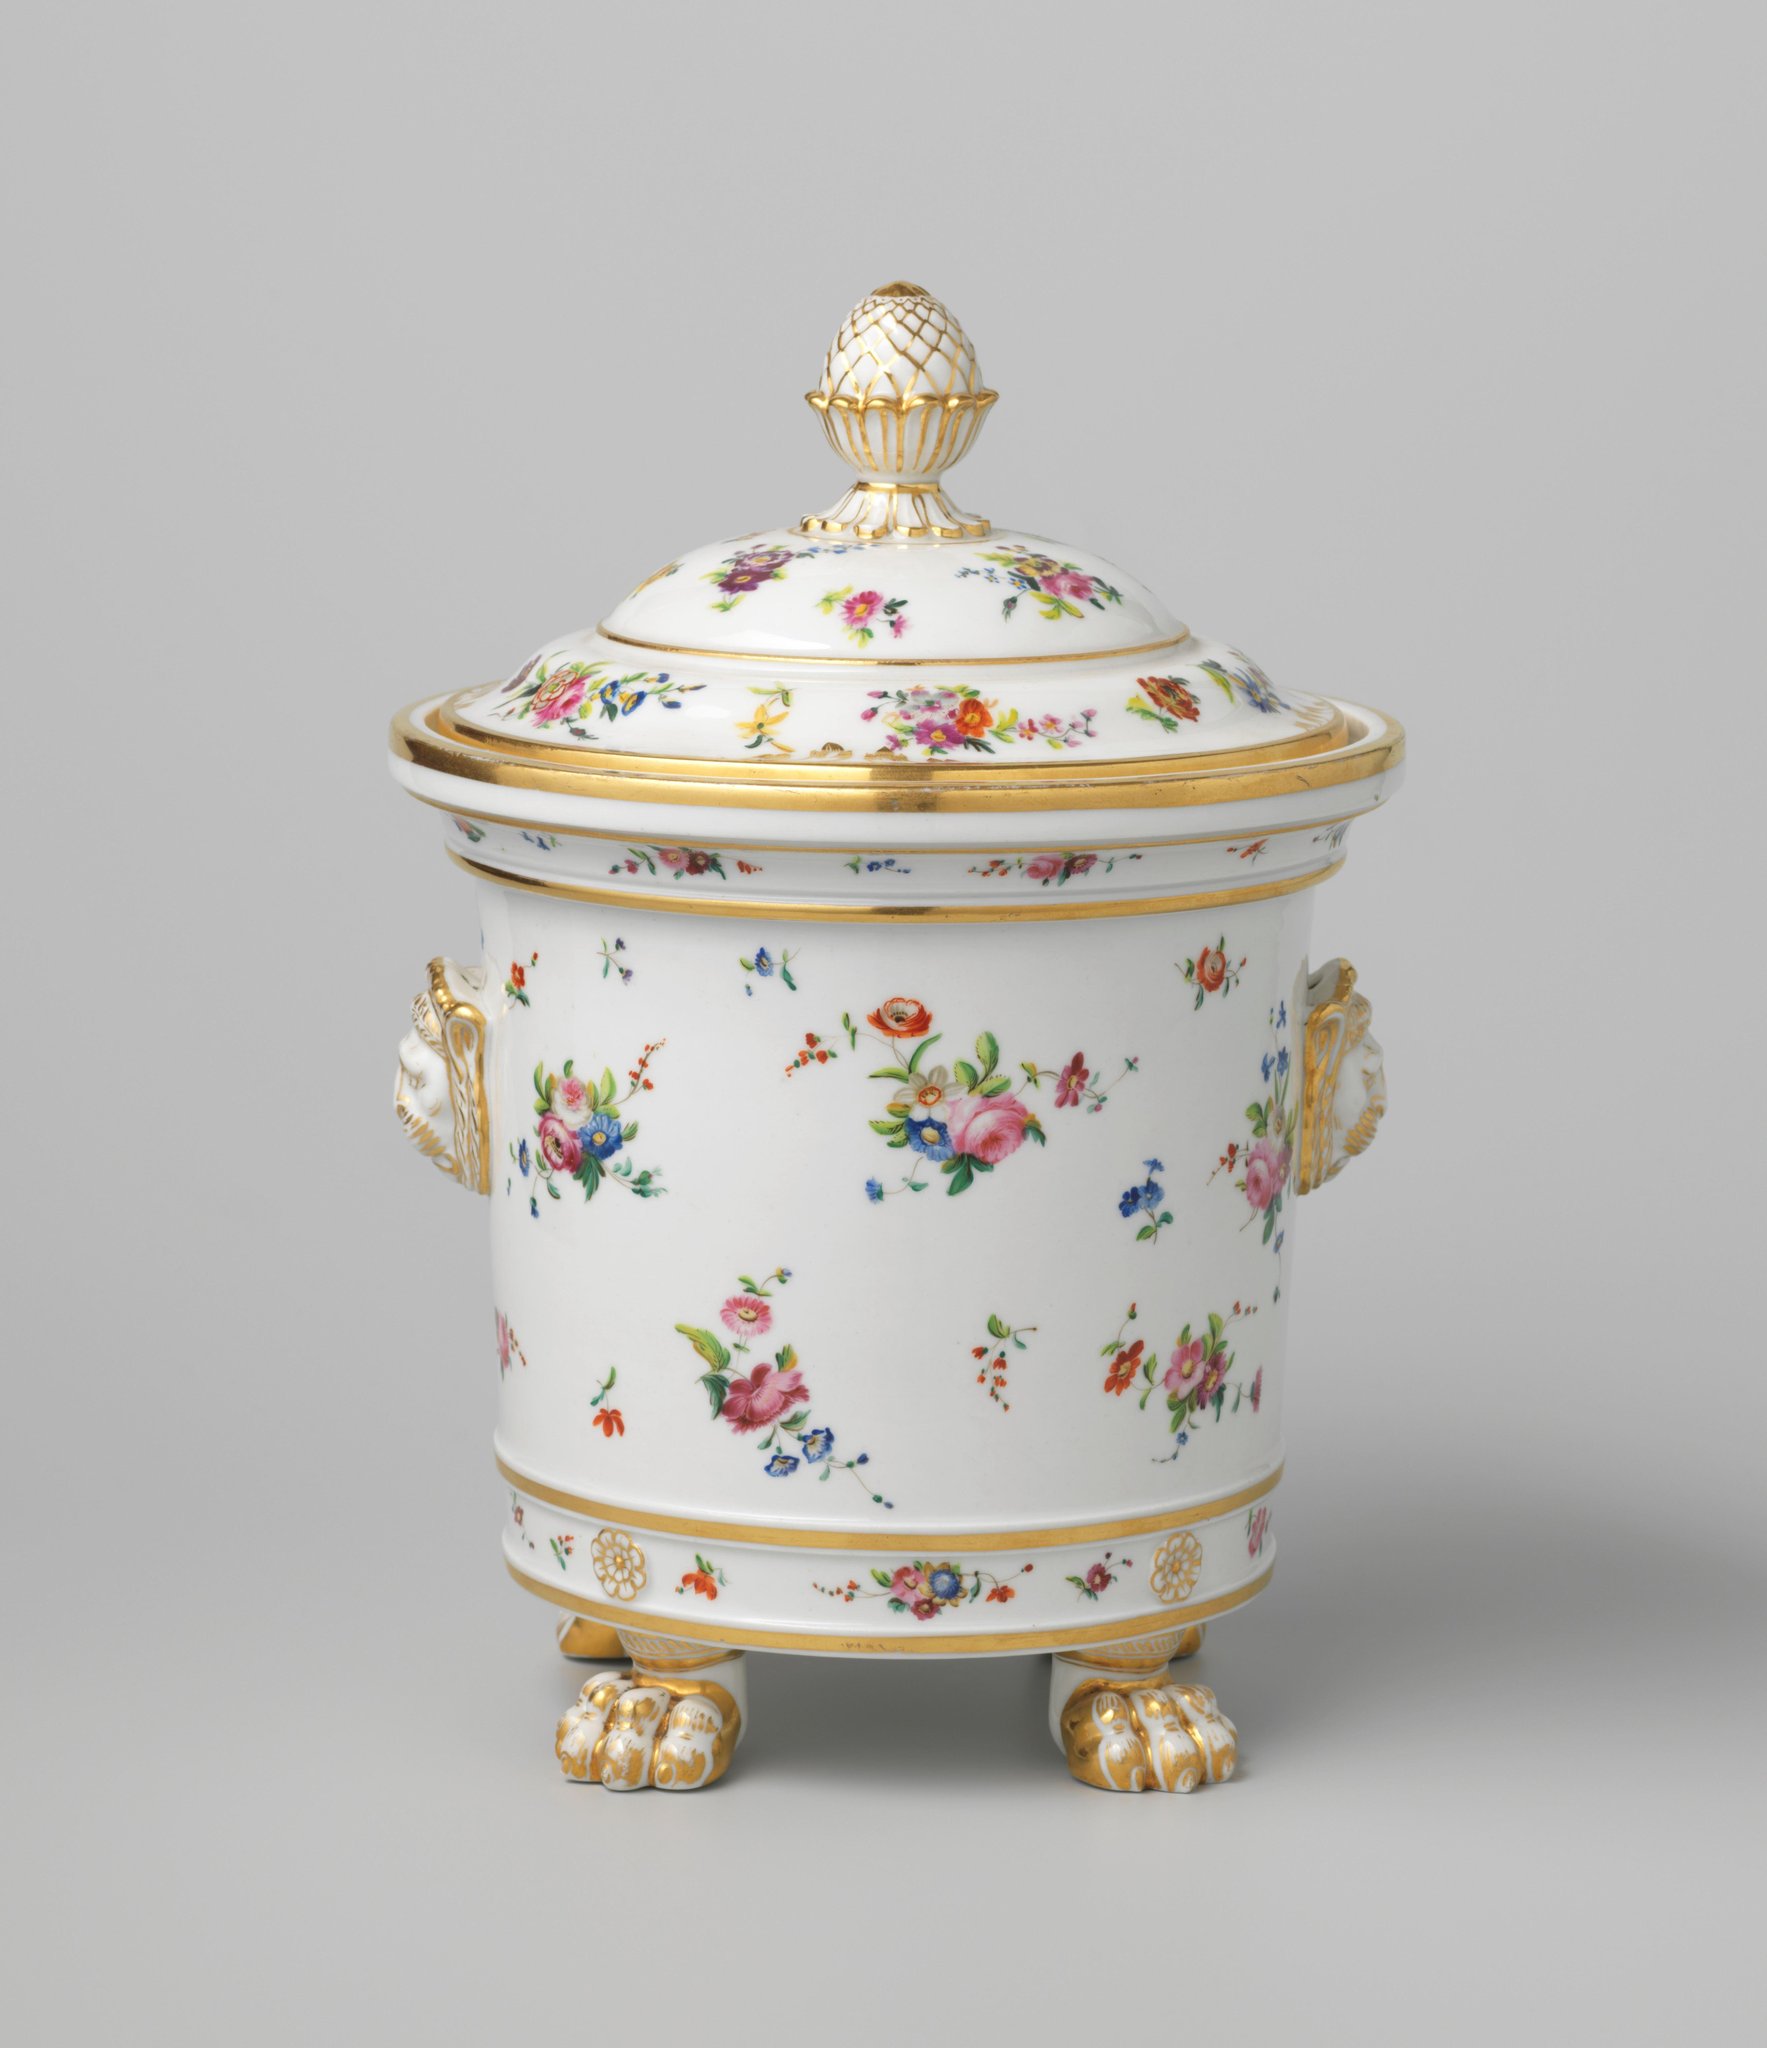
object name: kastanjevaas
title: Container of a chestnut vase with bouquets and flower sprays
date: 1839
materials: glaze, gold, paint, porcelain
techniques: firing, forming, gilding, turning, vitrification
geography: paris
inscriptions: mark: ‘o/ II’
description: Houder van een kastanjevaas van porselein, beschilderd op het glazuur in blauw, rood, roze, groen, geel, paars, zwart en goud. Versierd op de bodem met boeketten van verschillende bloemen en strooibloemen. Een profiel onder de iets spreidende rand, om de houder in de vaas te hangen. Gouden randen. Gemerkt op de onderzijde met o en II.